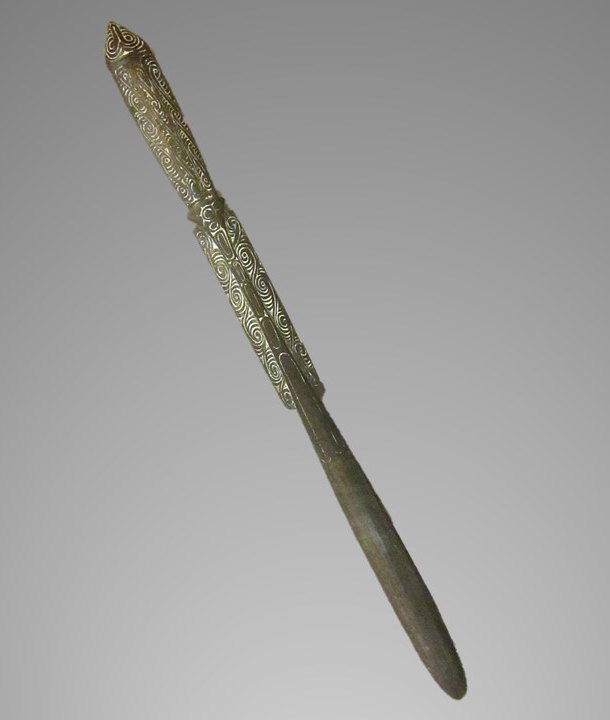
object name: time marker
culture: papua new guinean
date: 1867-1900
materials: wood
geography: papua new guinea